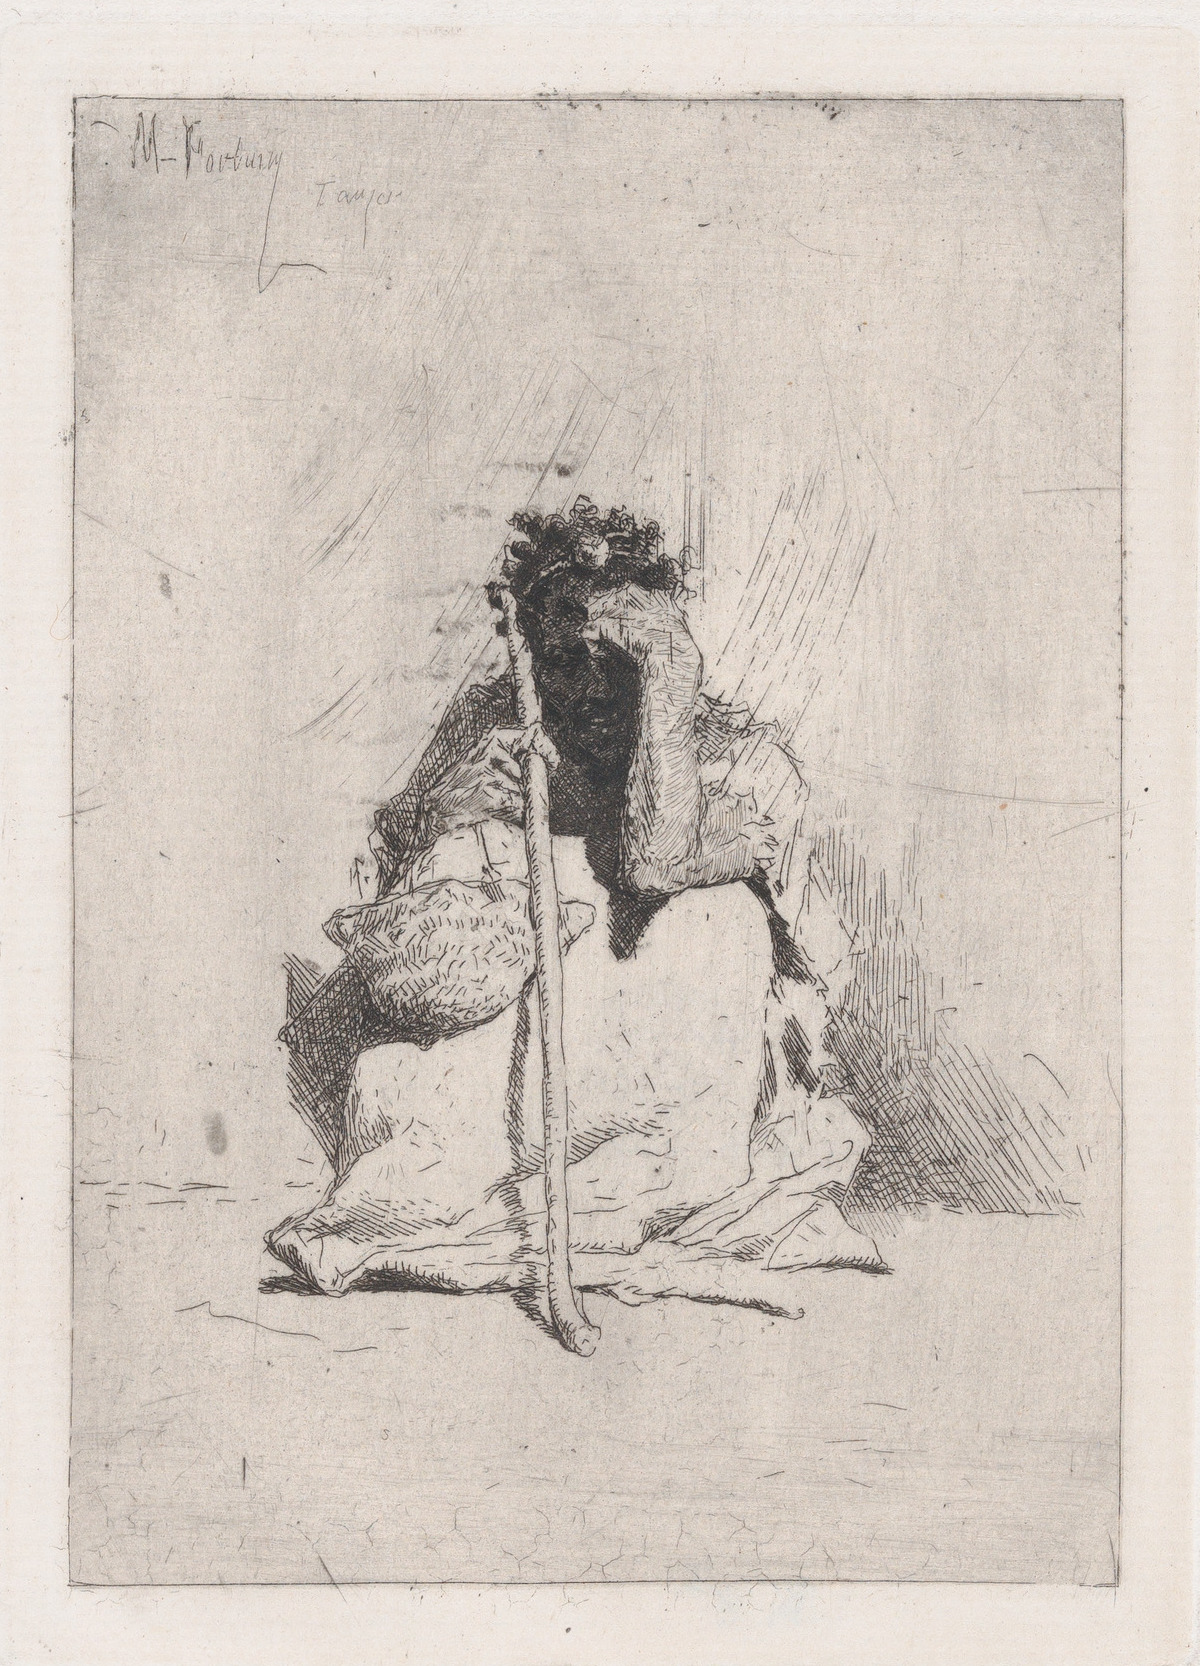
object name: print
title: A beggar, seated on the ground holding a stick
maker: mariano fortuny, 1838–1874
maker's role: artist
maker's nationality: spanish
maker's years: 1838-1874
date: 1862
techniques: etching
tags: men